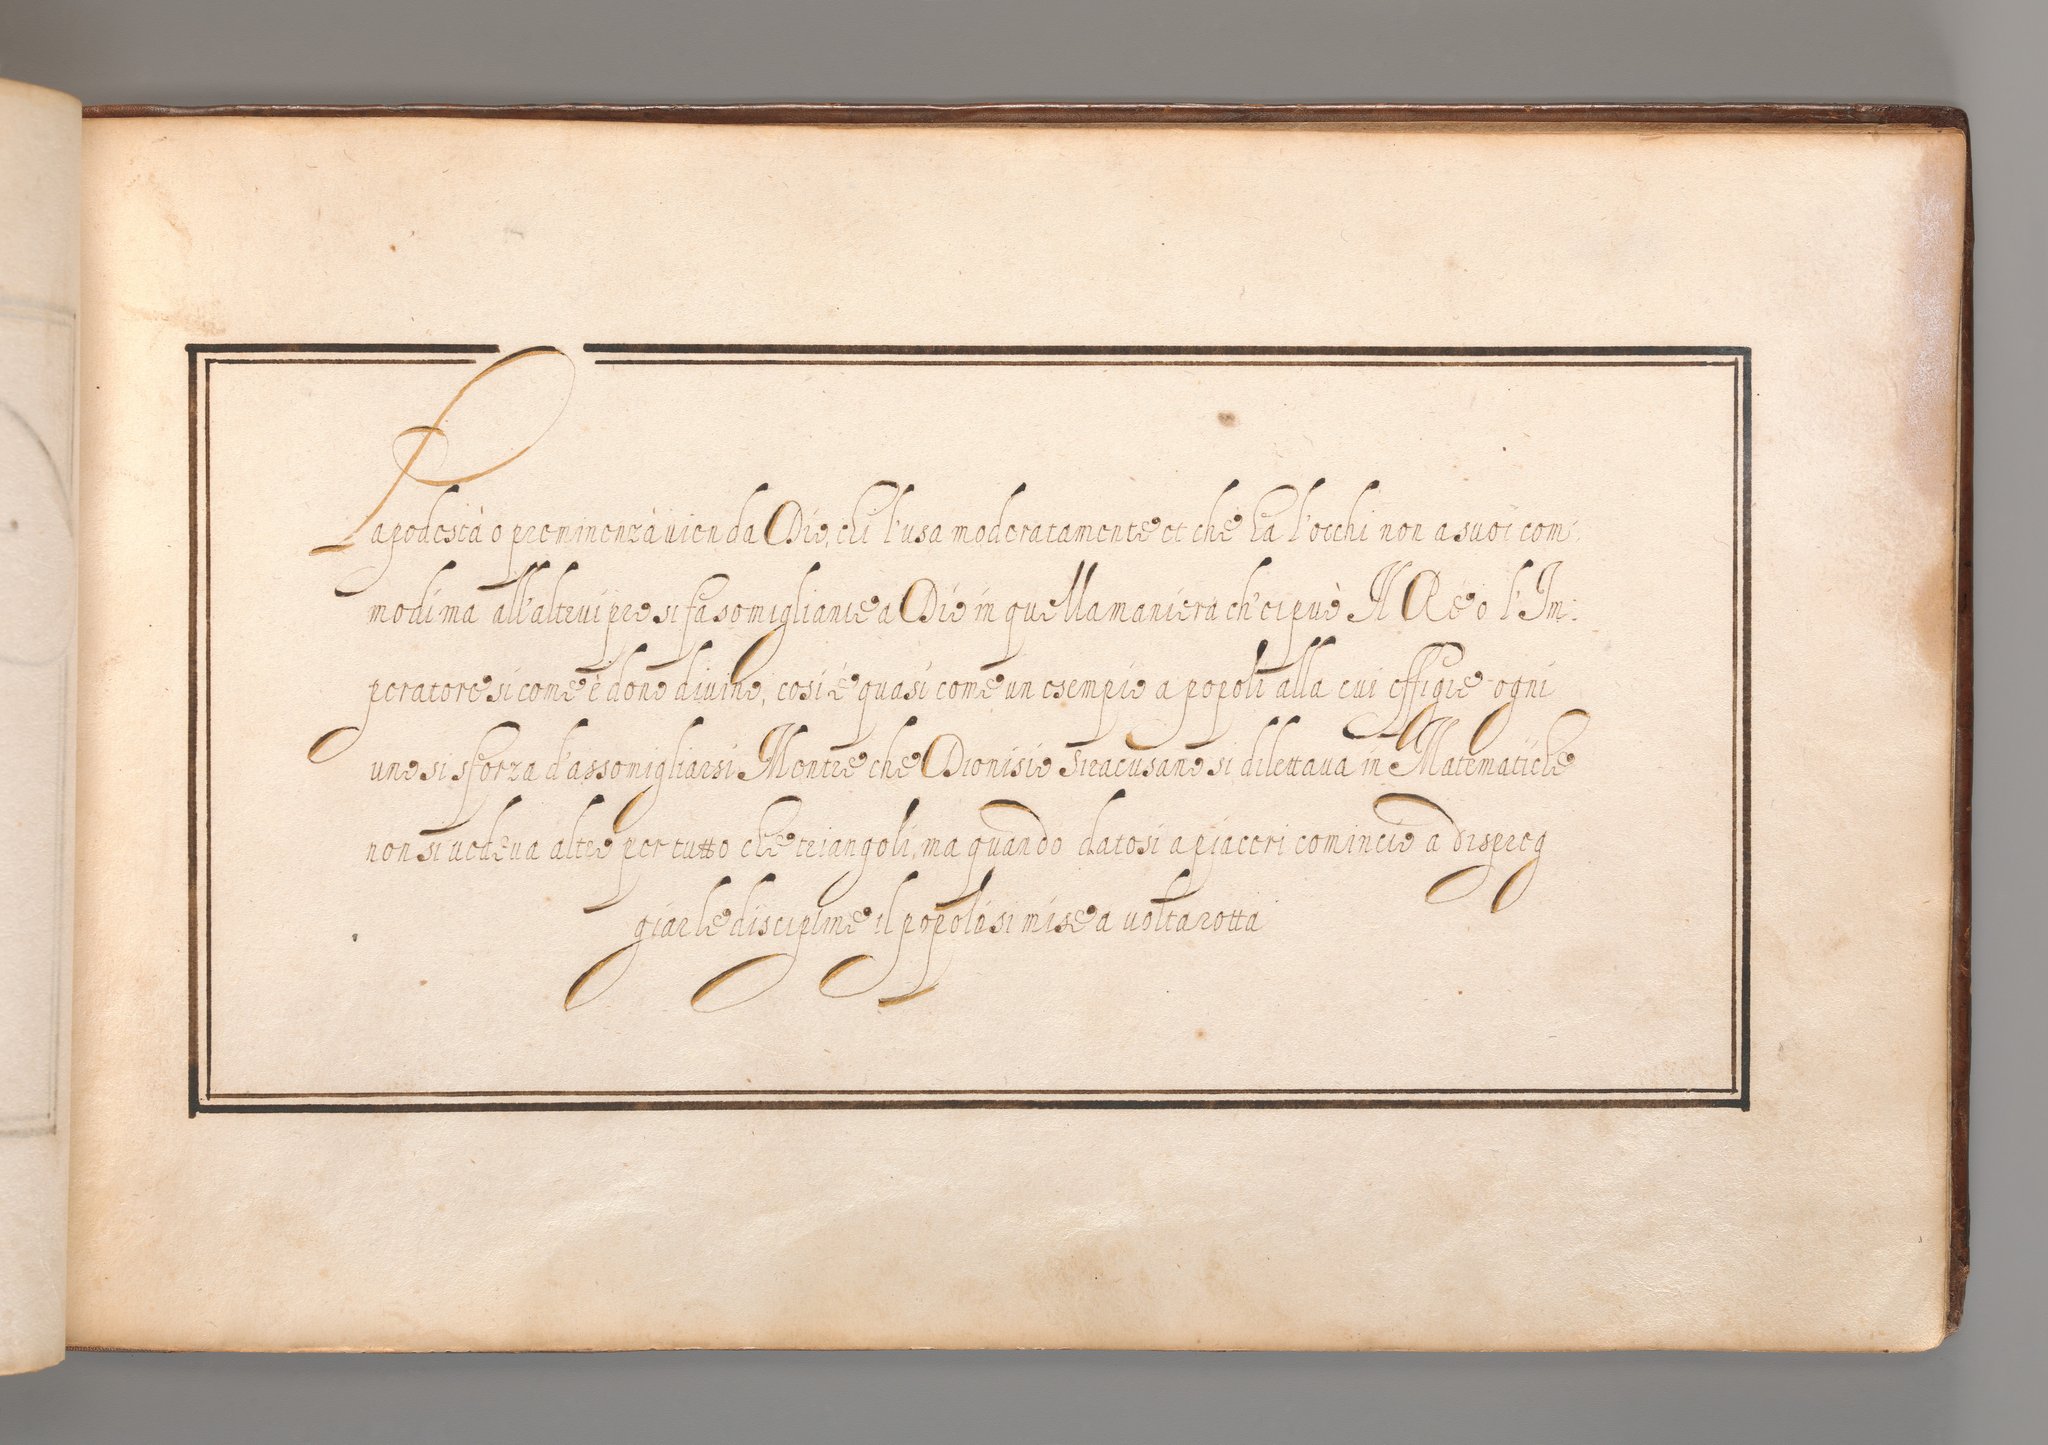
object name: album print ornament architecture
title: Calligraphic Exercise in Italian (Cursive Script)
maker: Anonymous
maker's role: artist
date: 1601-1633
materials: ink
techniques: pen